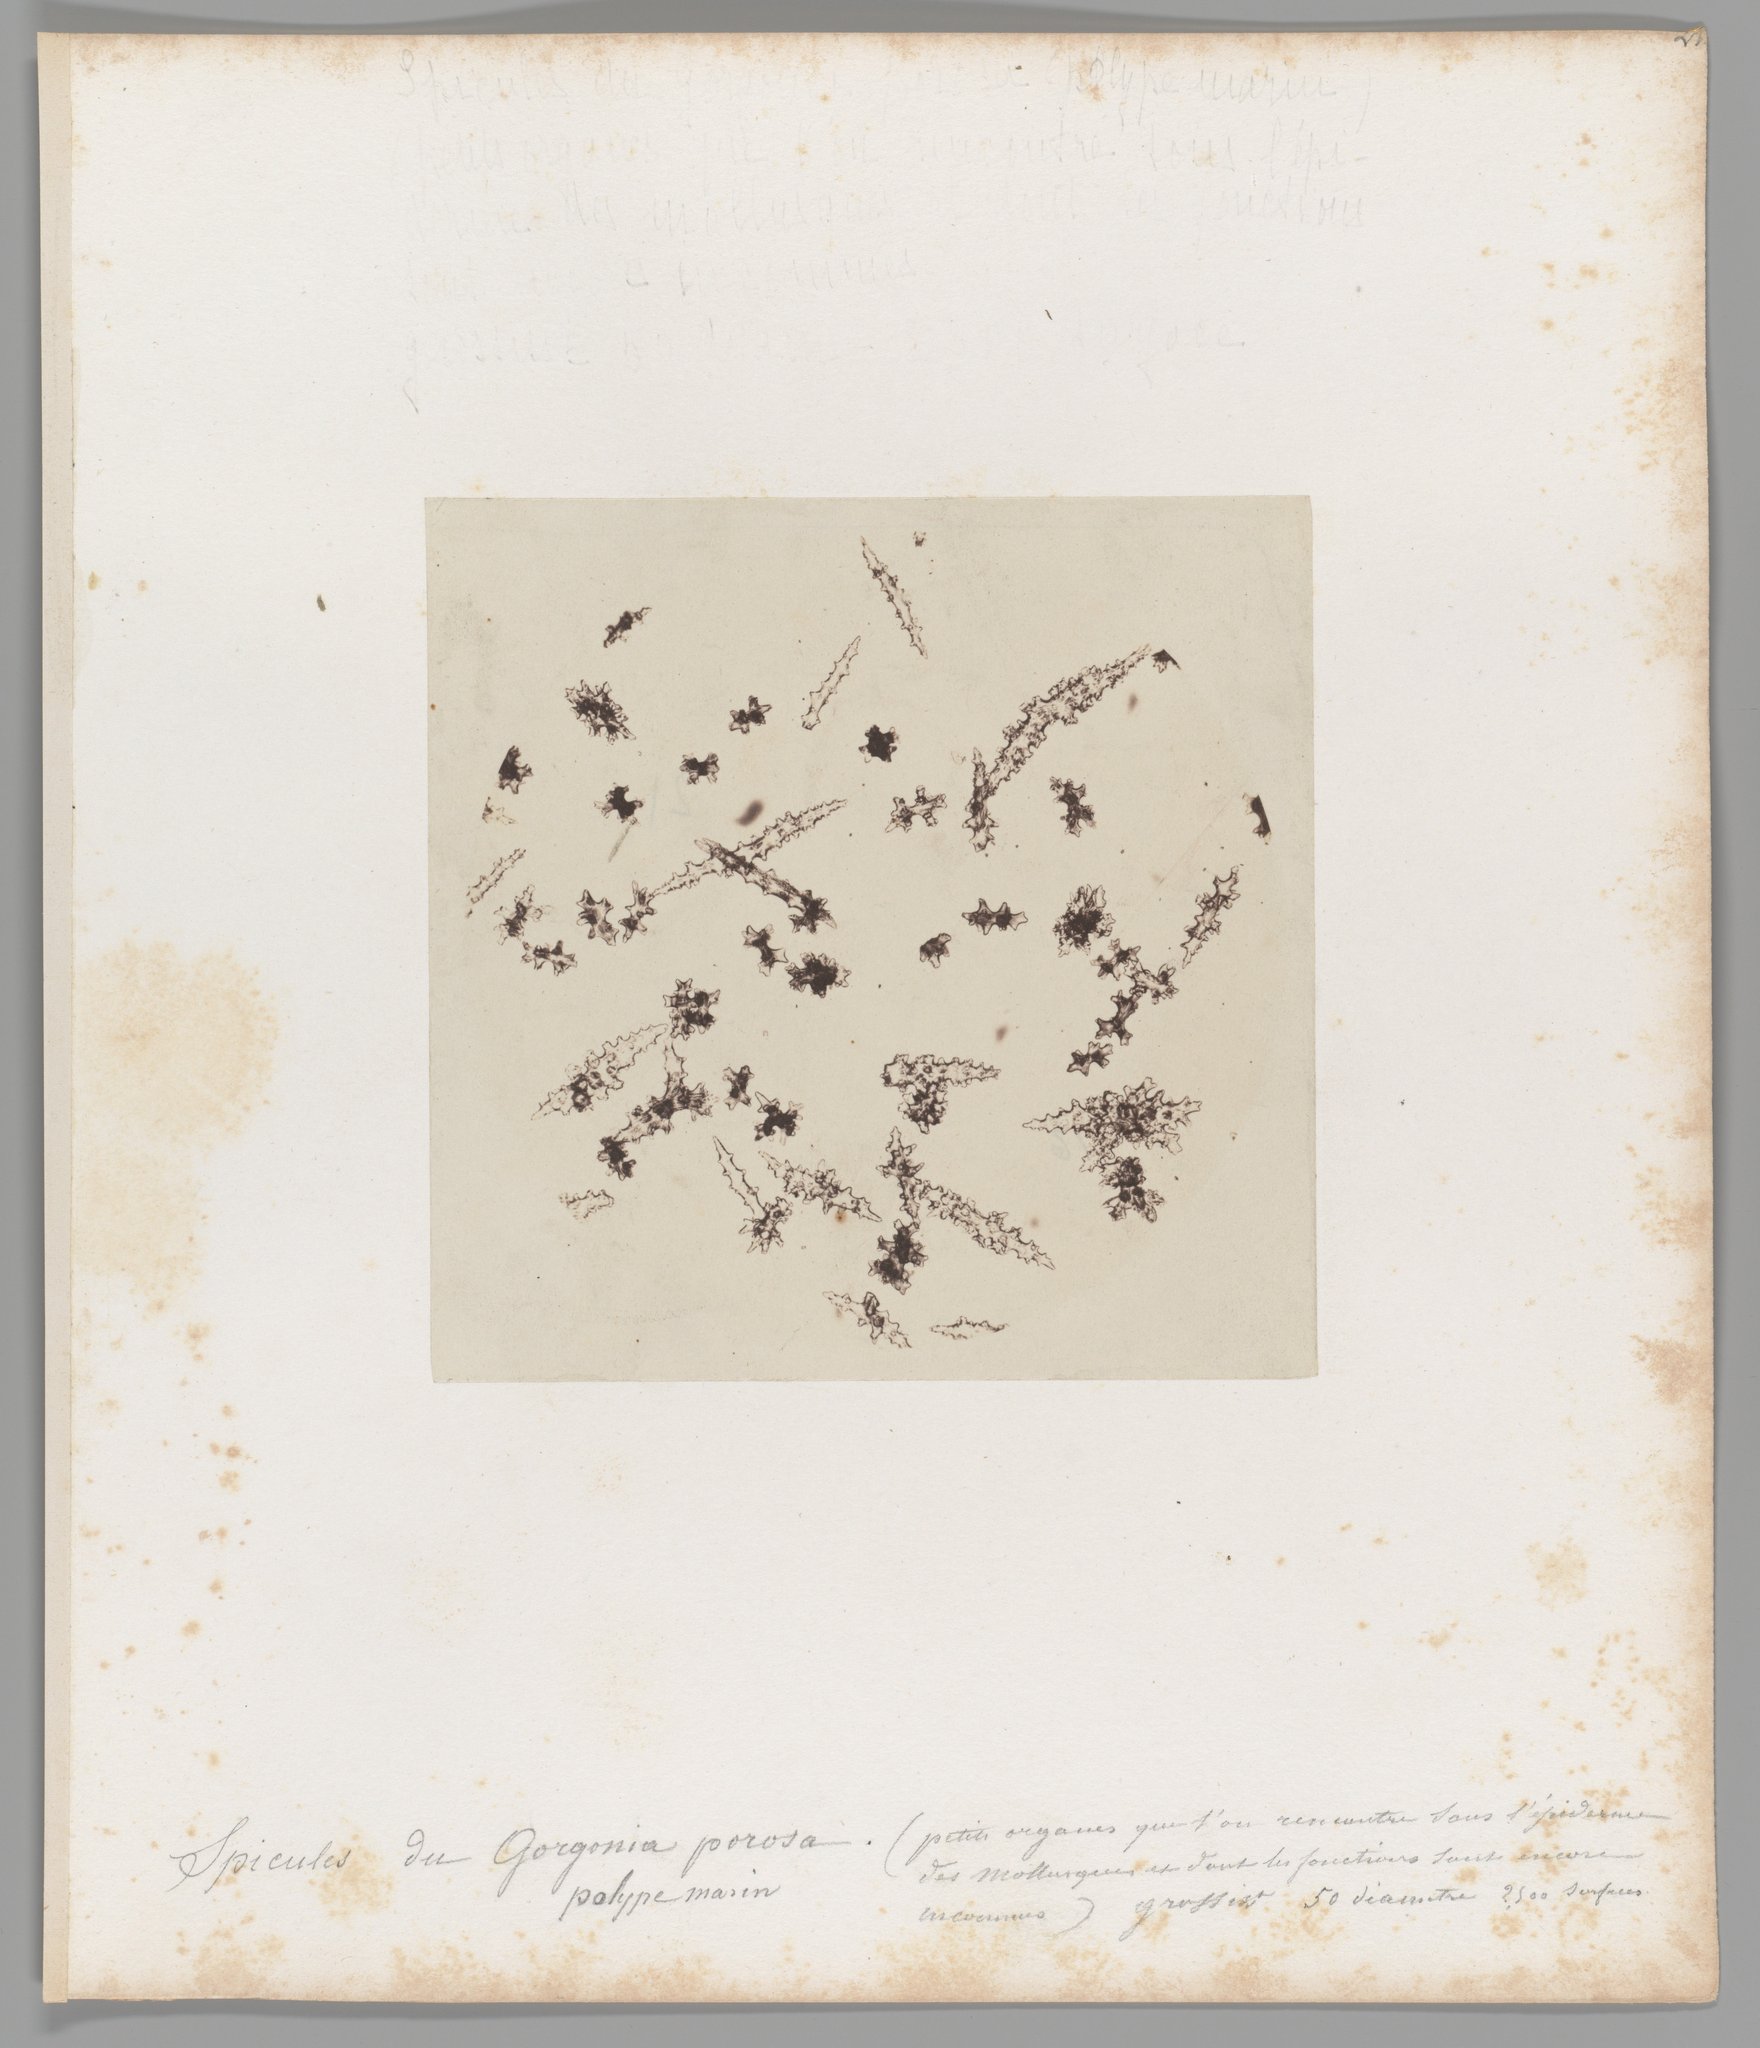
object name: photograph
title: [Untitled]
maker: auguste-adolphe bertsch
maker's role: artist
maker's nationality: french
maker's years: 1813-1871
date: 1853-1857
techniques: salted paper print